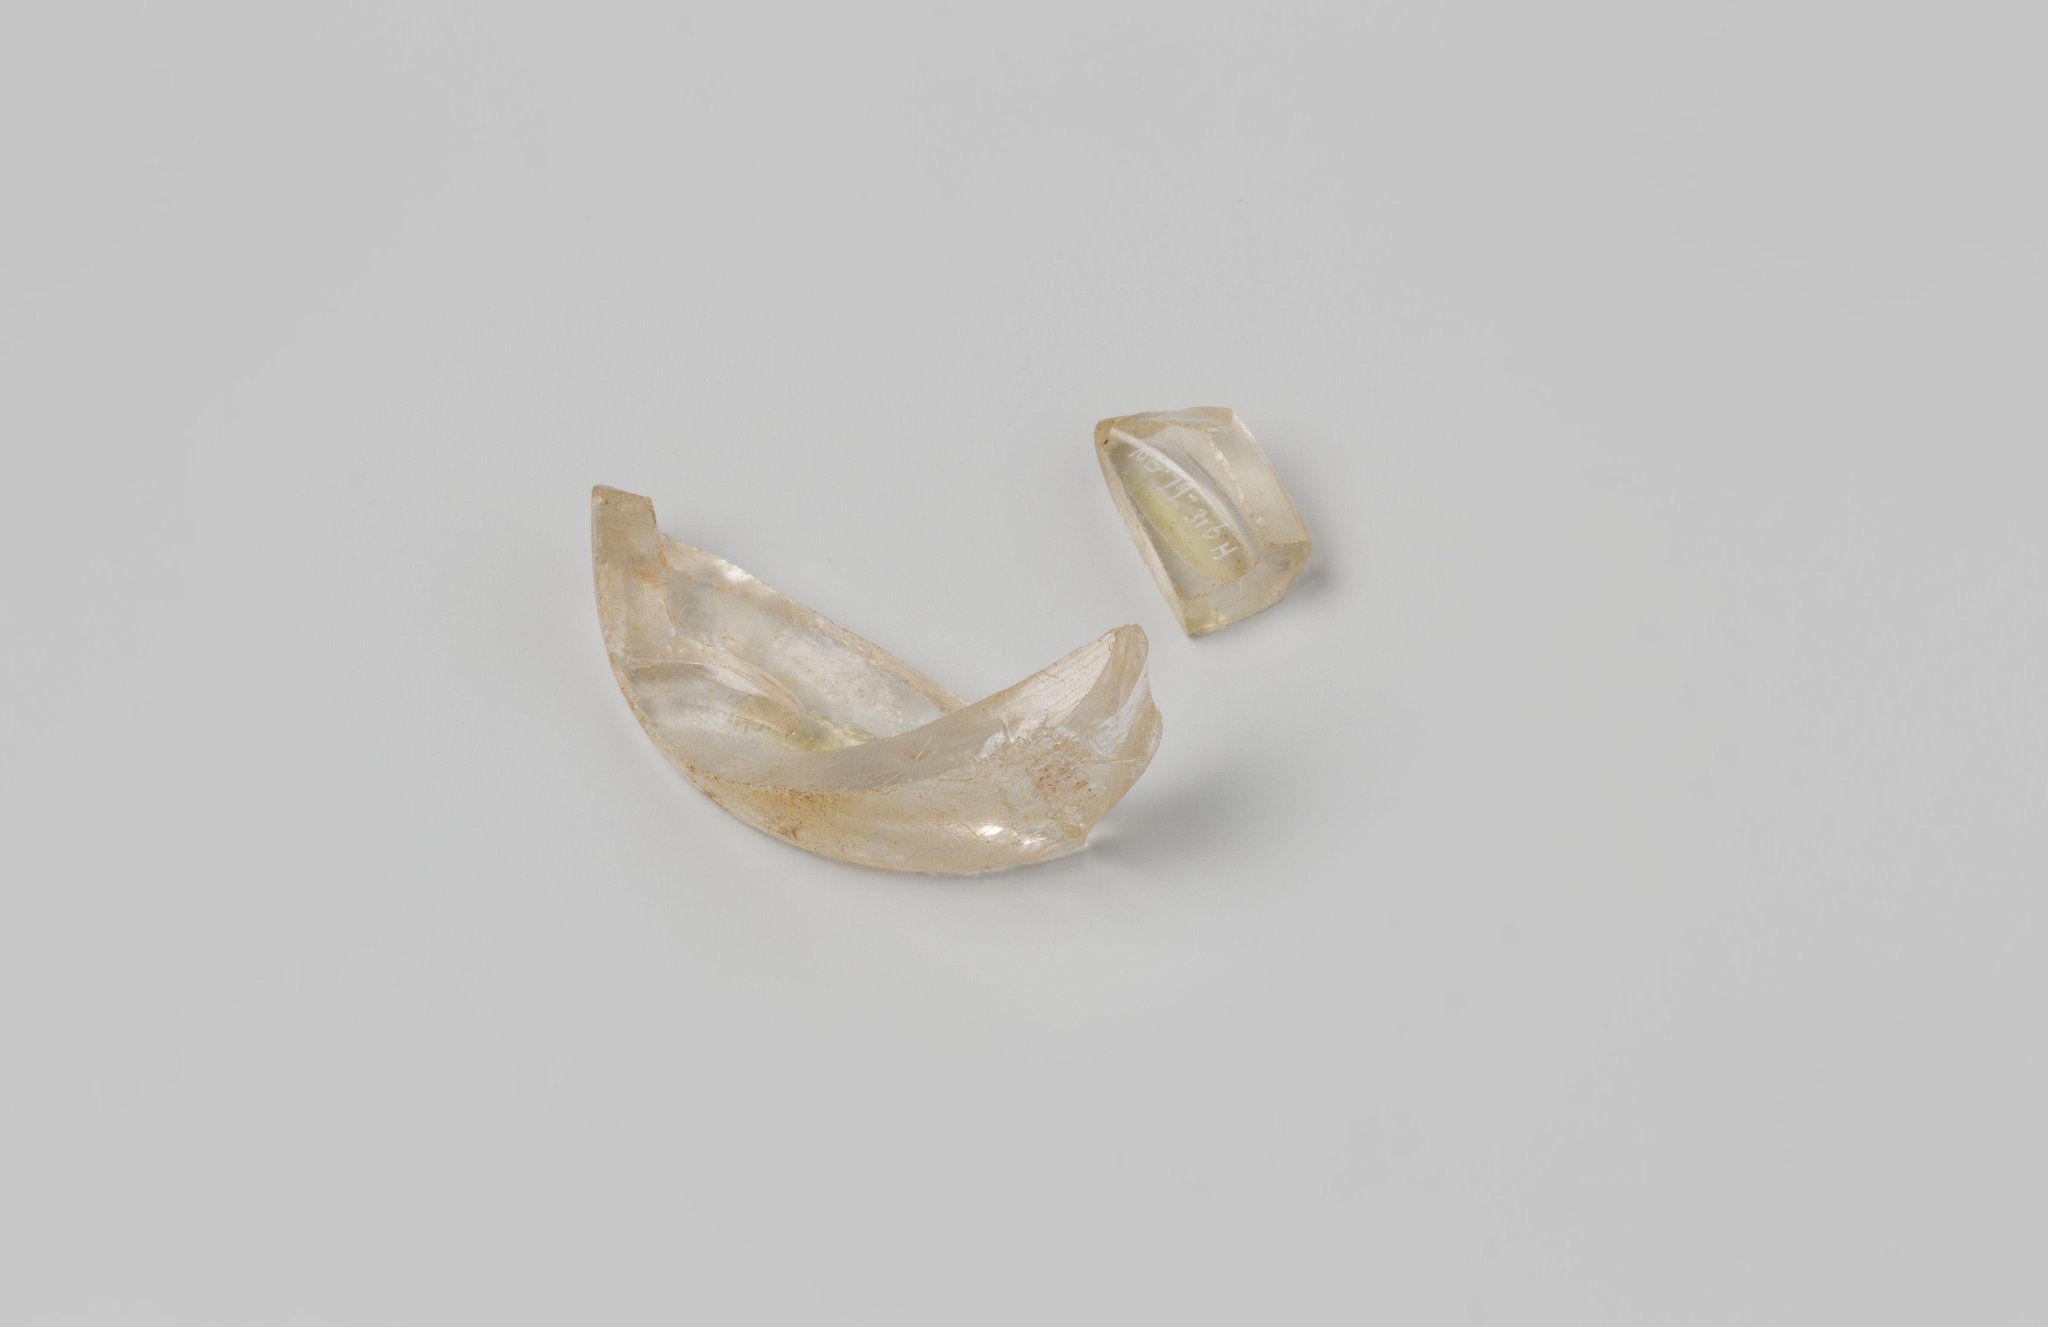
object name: tumbler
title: Fragment tuimelaar uit het wrak van de Oost-Indiëvaarder Hollandia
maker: Anonymous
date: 1700-1743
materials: glass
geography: netherlands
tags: verenigde oostindische compagnie, hollandia (schip), annet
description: Base, fragm, circular, flat, straight sides. Tumbler.